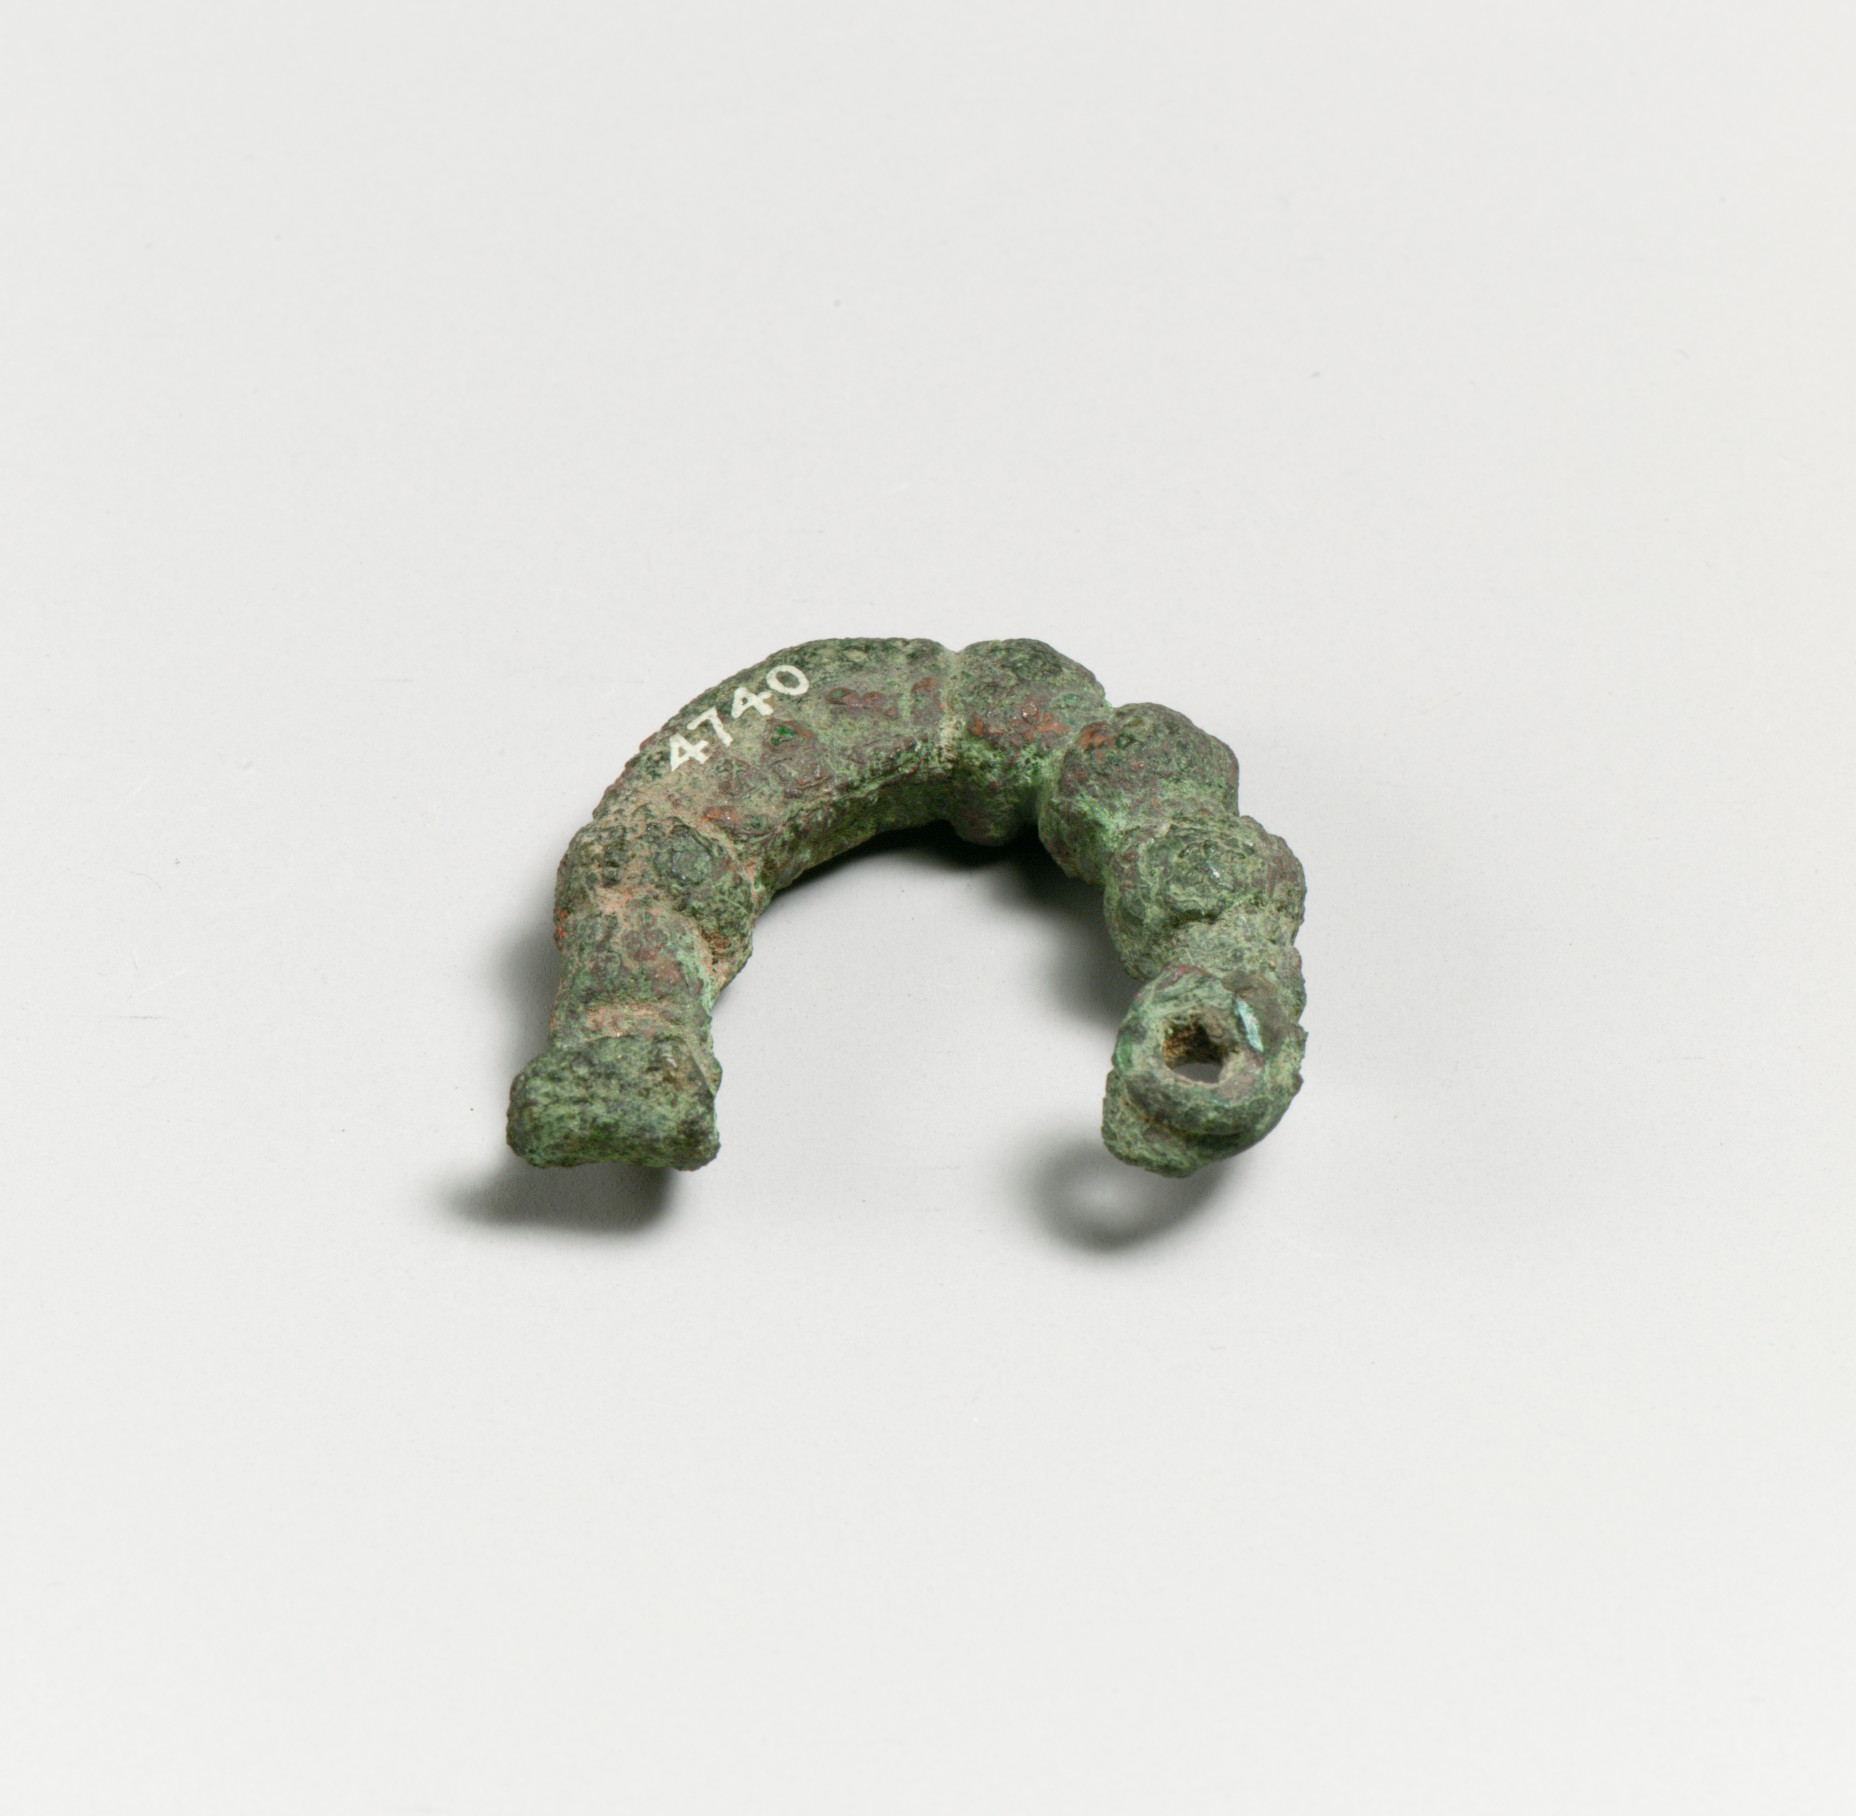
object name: fibula, fragment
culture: greek, cypriot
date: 7000-30 BCE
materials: bronze